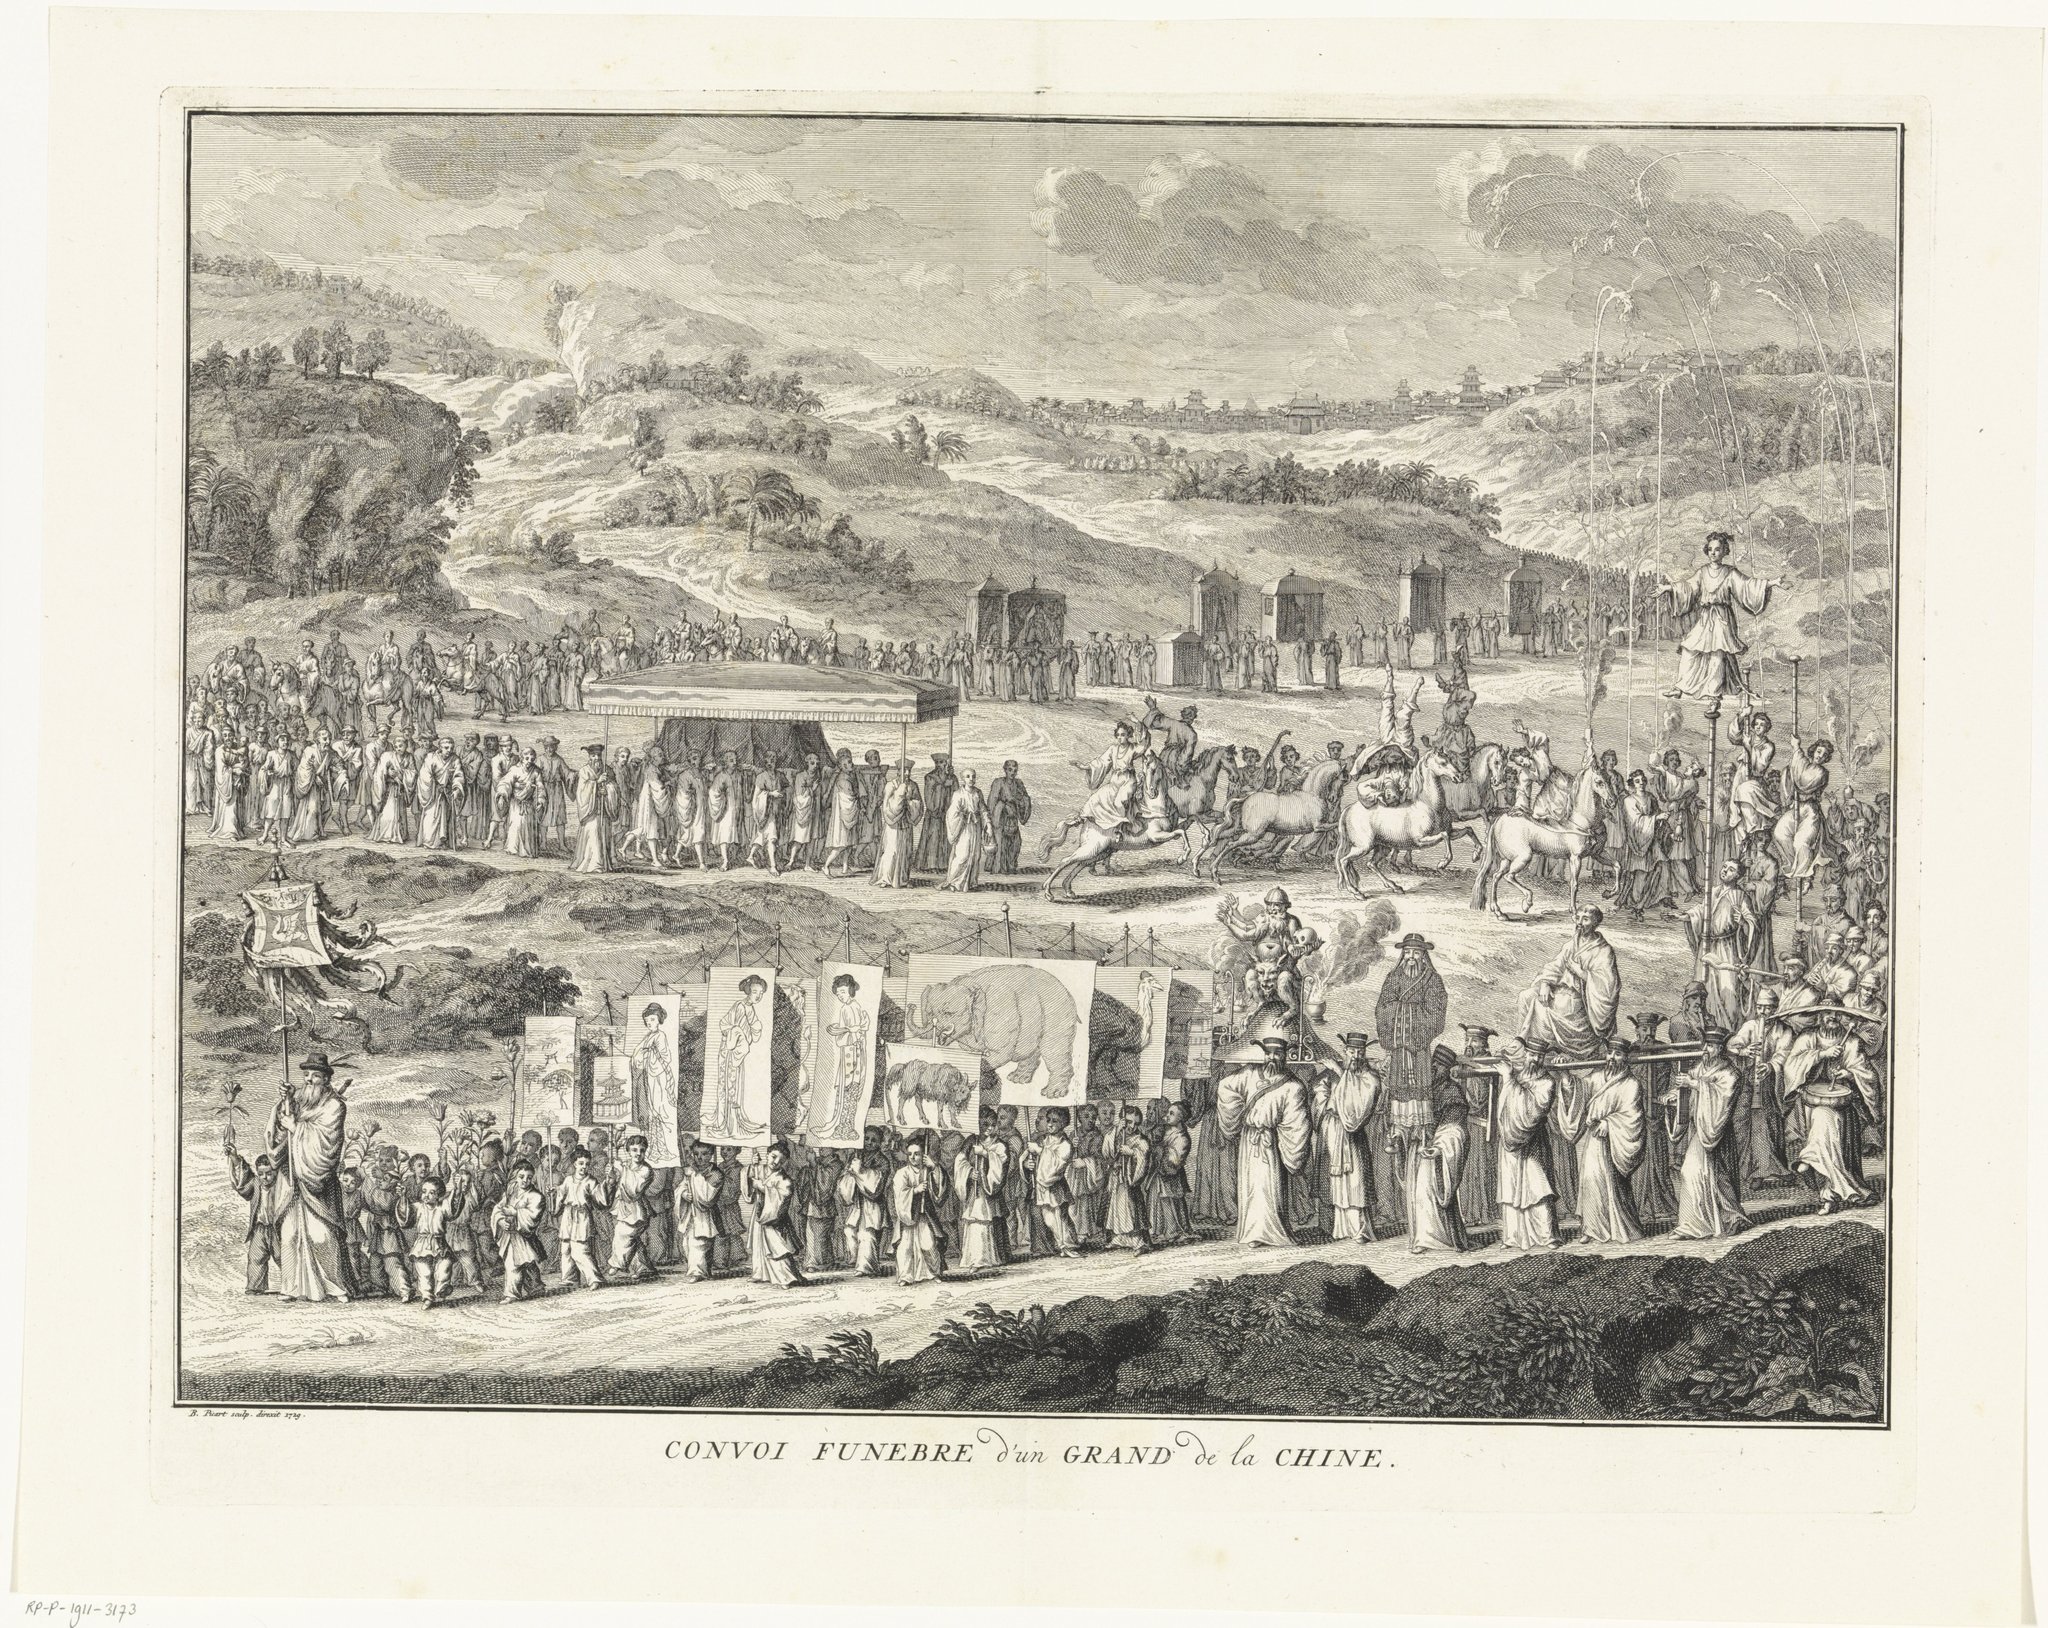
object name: book illustration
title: Convoi Funebre d'un Grand de la Chine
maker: bernard picart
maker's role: draughtsman, print maker, publisher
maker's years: 1673-1733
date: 1729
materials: paper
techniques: engraving, etching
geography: amsterdam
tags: cortege, funeral procession, traditional chinese religions, representations ~ gods, demi-gods, heroes, etc. (traditional chinese religions)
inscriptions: collector's mark: Lugt 2228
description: De rouwstoet van een vooraanstaande Chinees. Vooraan lopen kinderen met banieren, daarachter worden verschillende godenbeelden gedragen, lopen muzikanten en acrobaten en wordt vuurwerk afgestoken. Daarna dragen mannen de kist met de overledene. Achter de kist komt de familie van de overledene. Enkele vrouwen worden in draagstoelen gedragen.